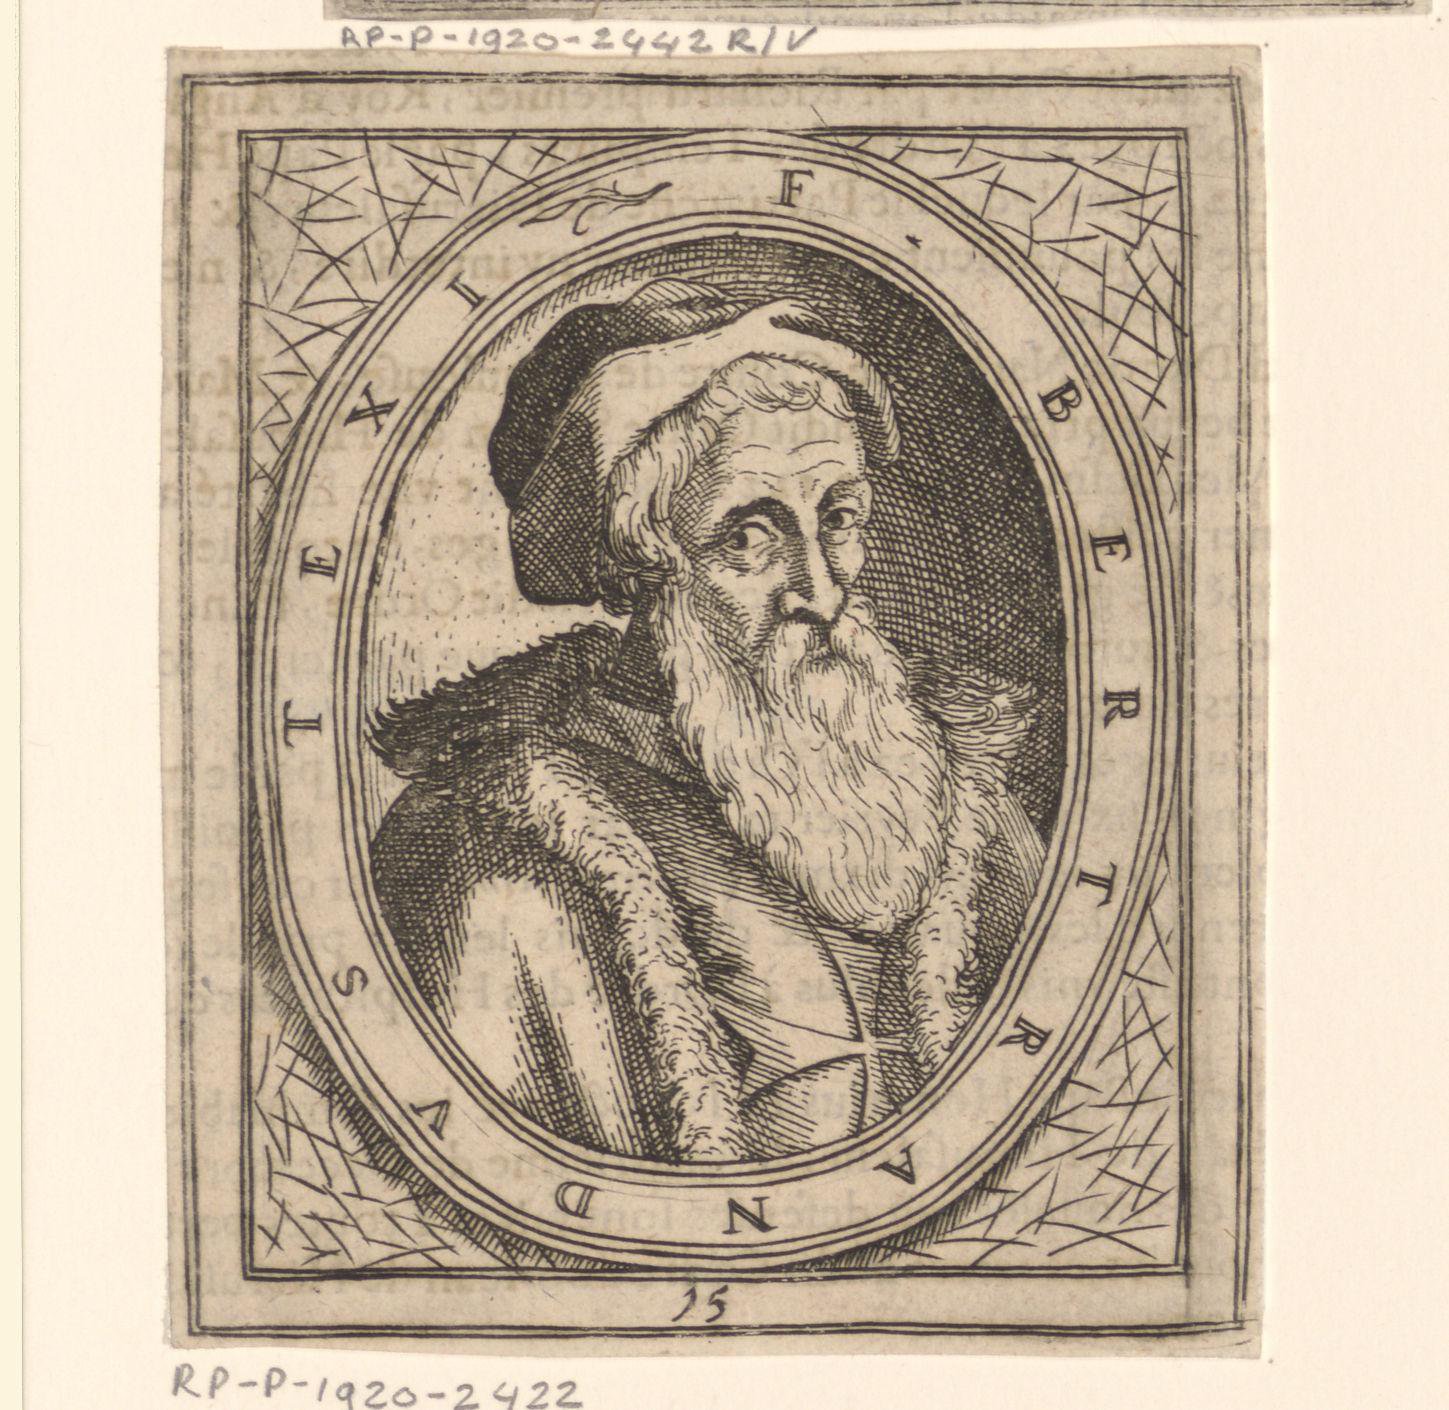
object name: print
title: Portret van Bertrand de Thessy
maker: Anonymous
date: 1643-1659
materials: paper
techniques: engraving, etching, letterpress printing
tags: historical persons, military orders, e.g.: knights templars, knights of malta, teutonic knights ~ roman catholic church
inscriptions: collector's mark: Lugt 2228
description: Prent mogelijk uit: Baudoin, Jean. Histoire des chevaliers de l'ordre de s. Jean de Hierusalem (...). Parijs: Jacques Dallin, 1643. Of uit: Baudoin, Jean. Histoire des chevaliers de l'ordre de s. Jean de Hierusalem (...). Parijs: Thomas Jolly, 1659.